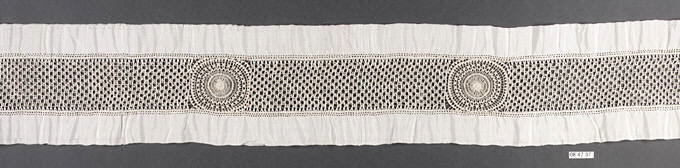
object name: border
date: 1801-1900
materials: silk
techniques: embroidery